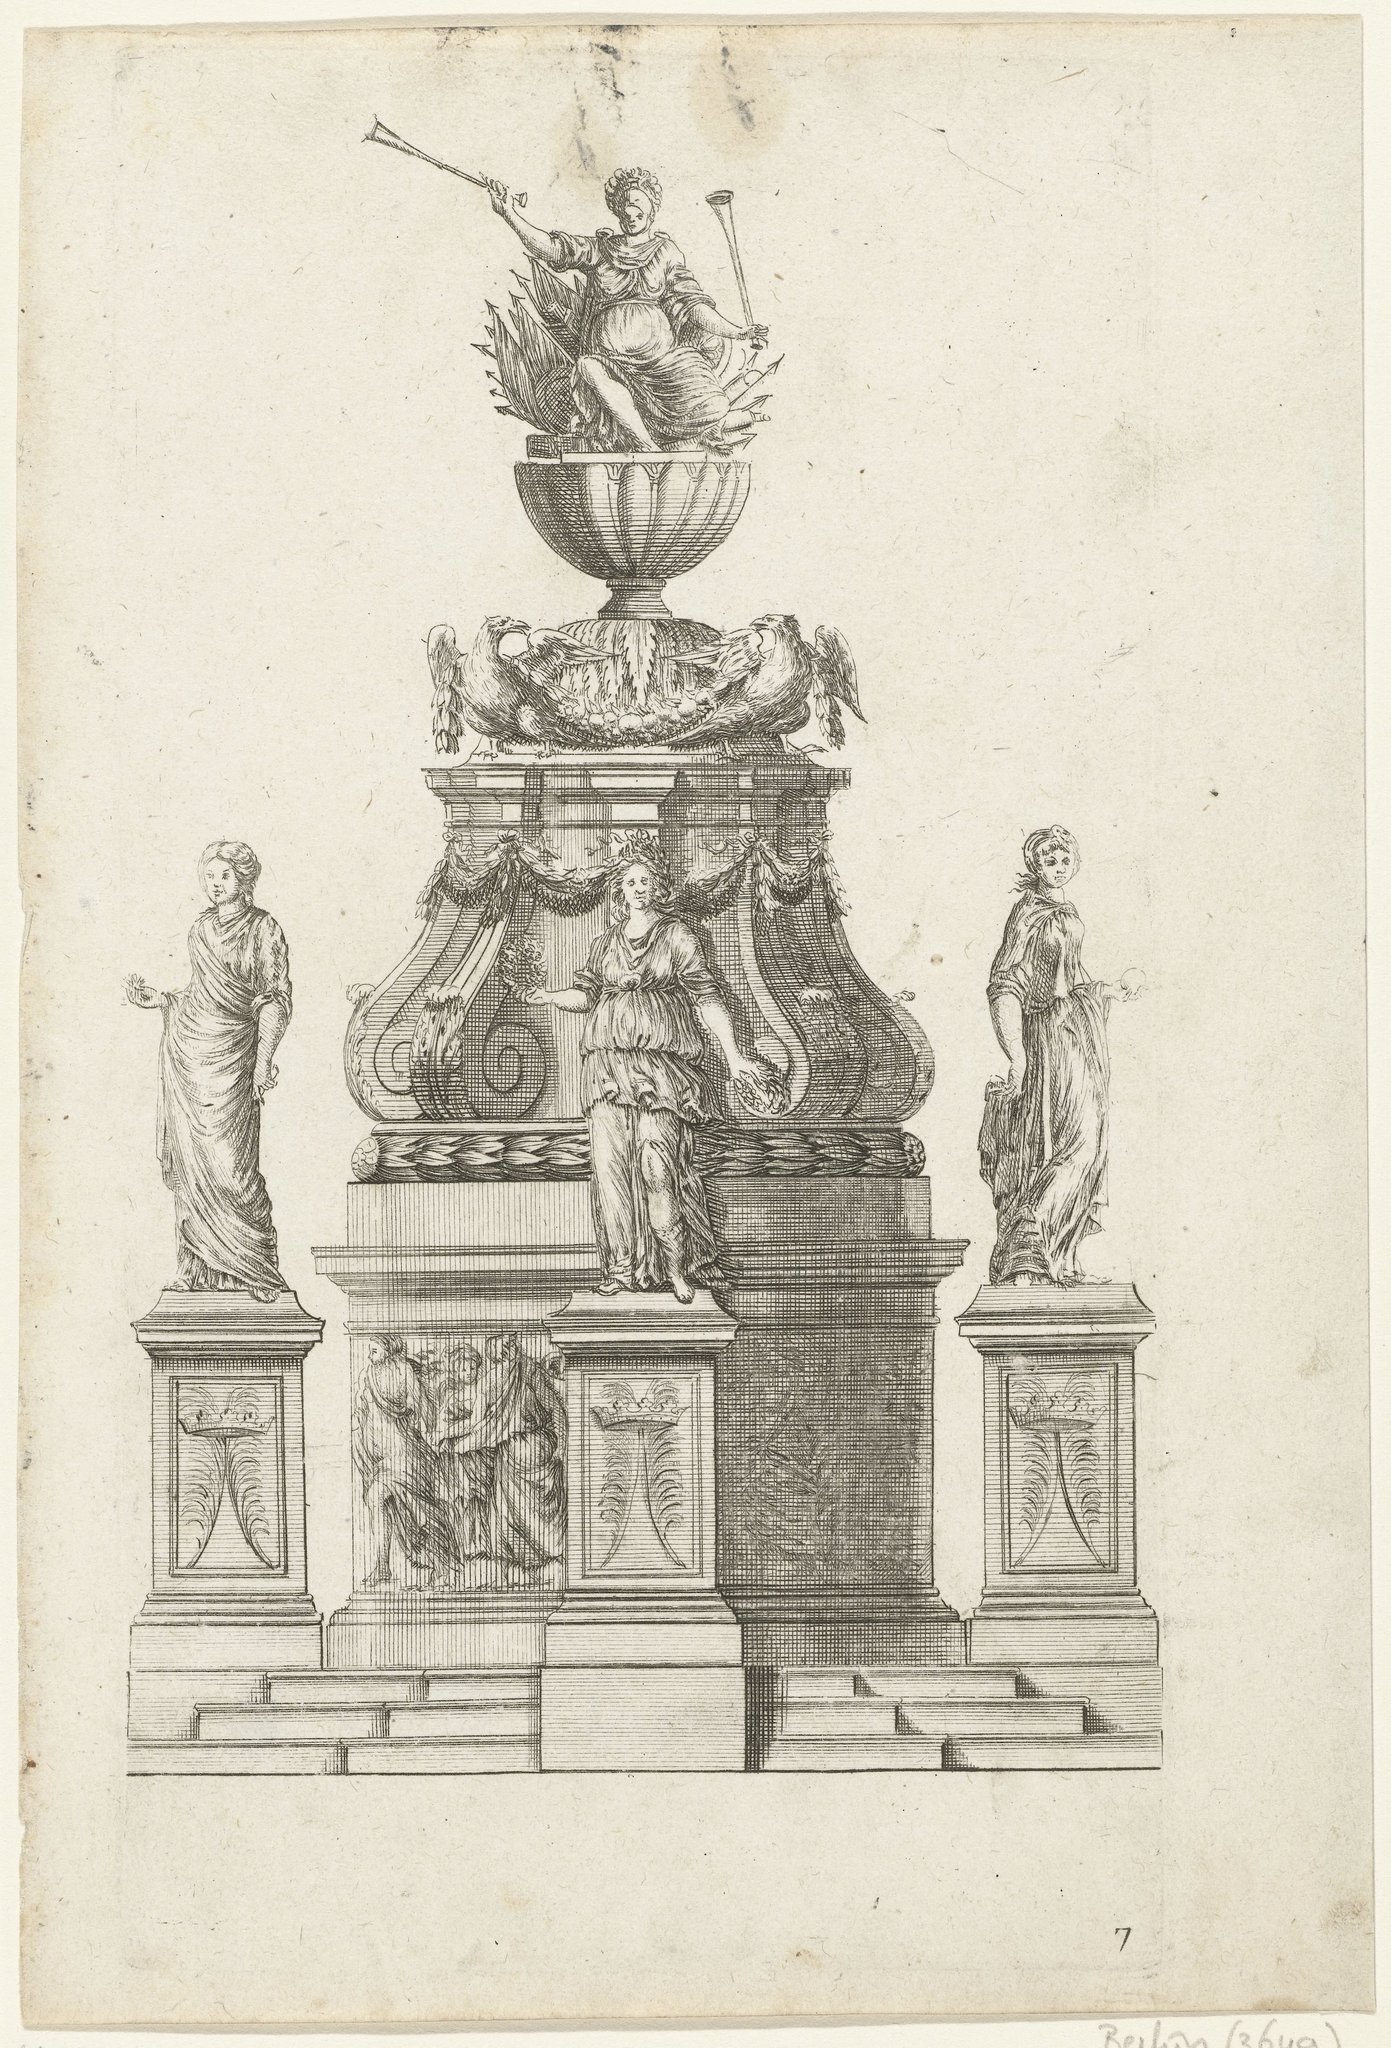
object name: ornament print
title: Rond grafmonument met bas-reliëf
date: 1629-1716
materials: paper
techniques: engraving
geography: paris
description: Bovenop zit Minerva (?). Uit eerste editie.